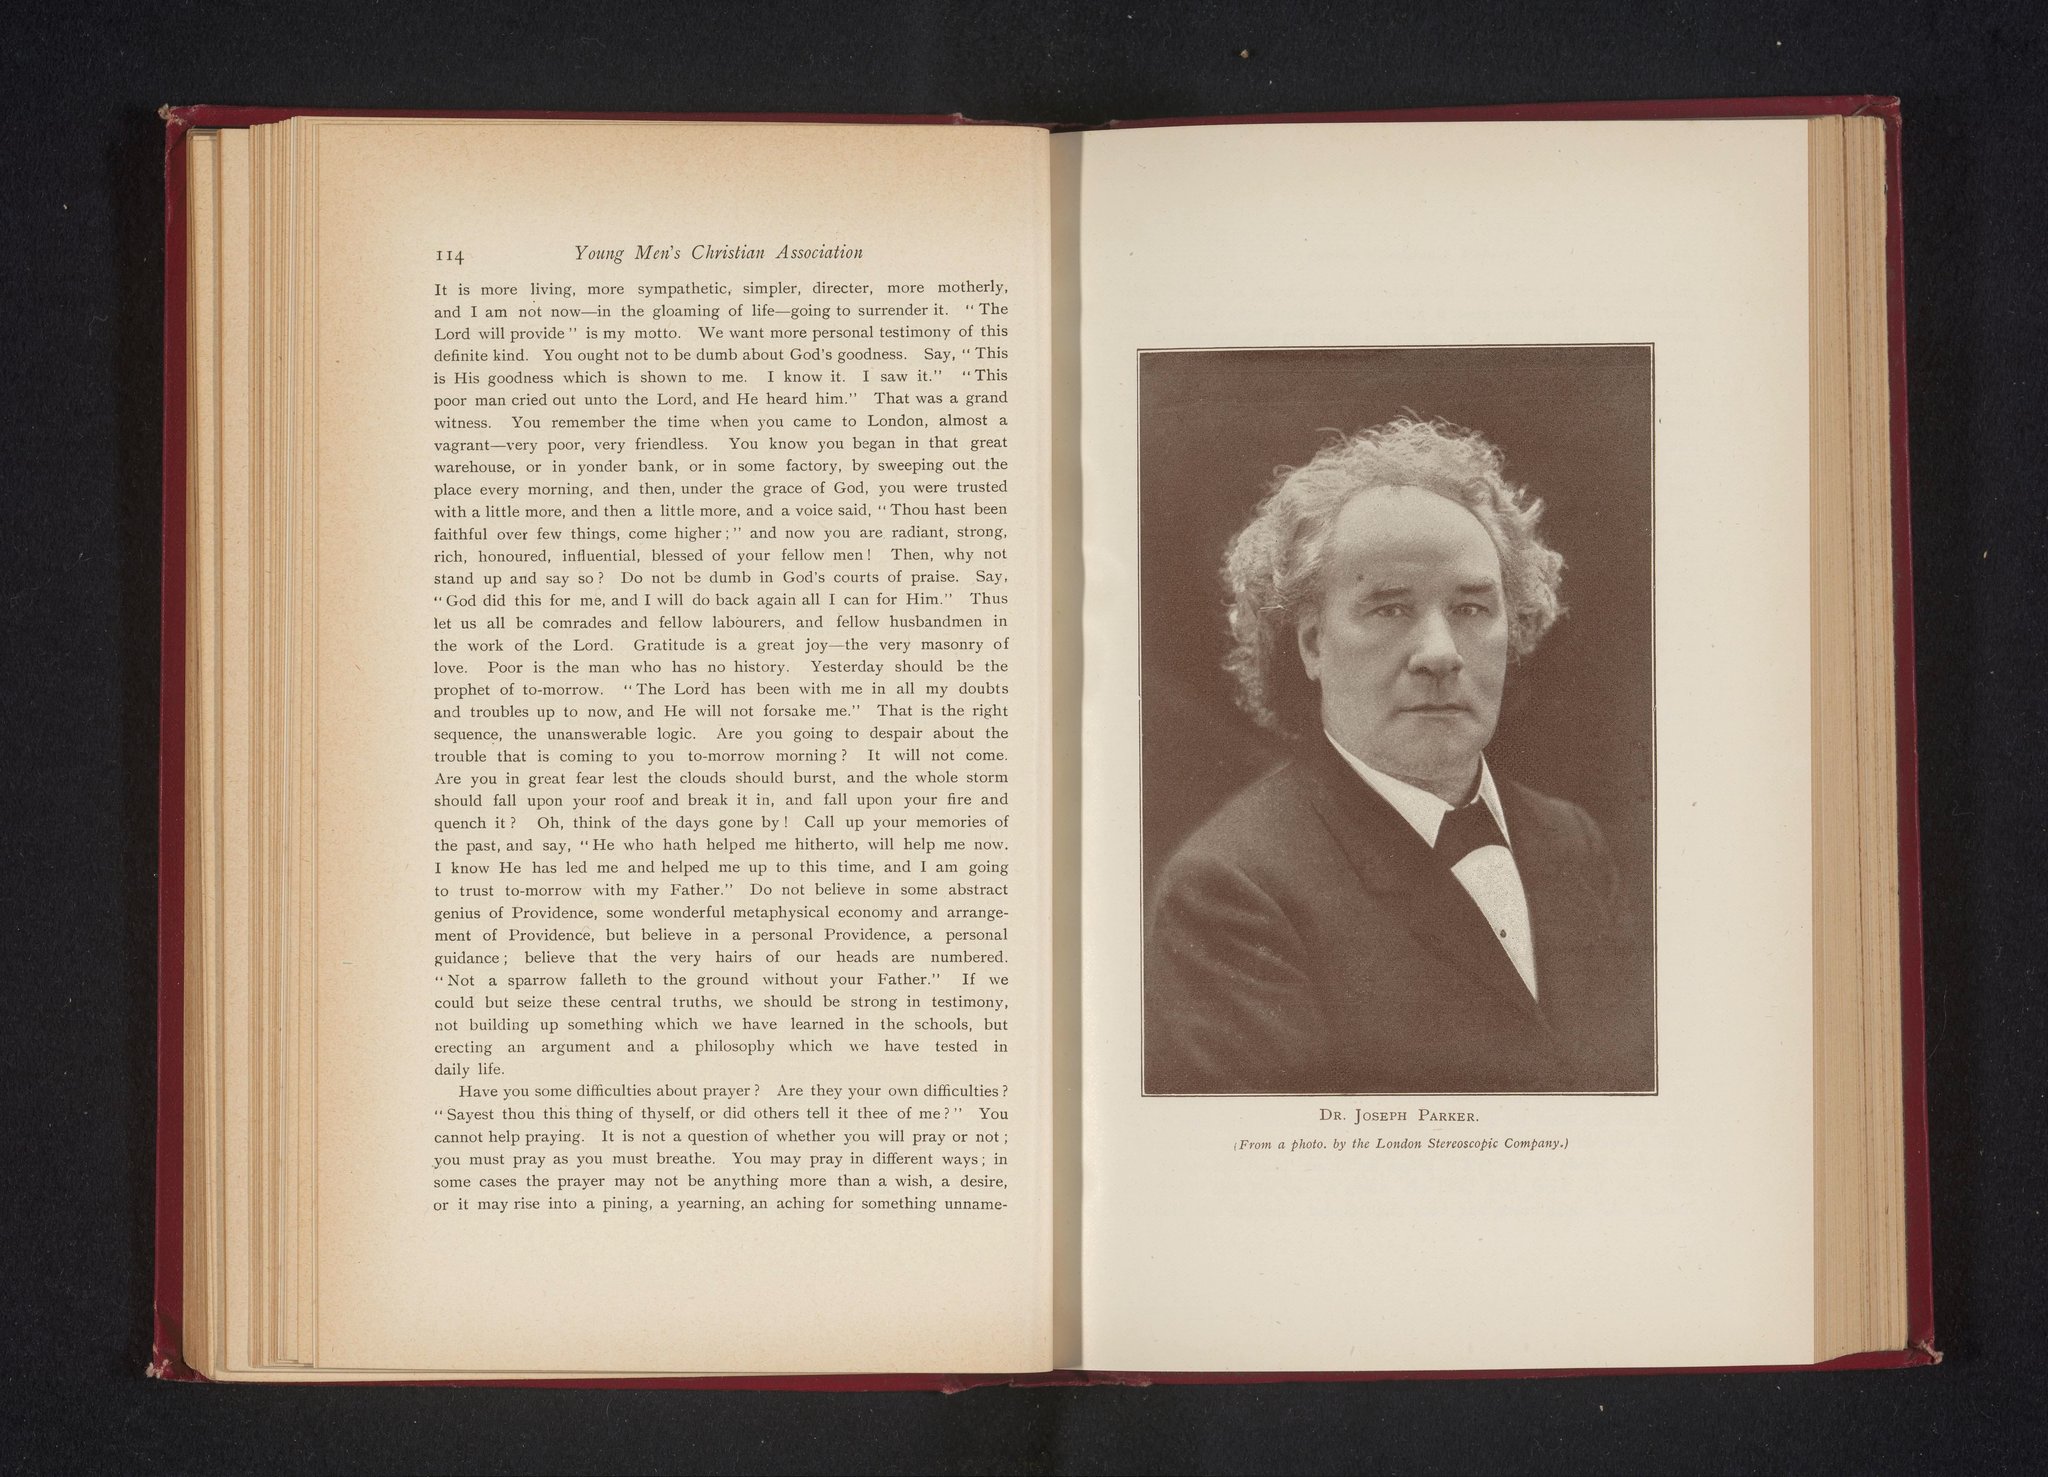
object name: page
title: Portret van Joseph Parker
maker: Anonymous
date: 1890-1895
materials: paper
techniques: autotype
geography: london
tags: historical persons